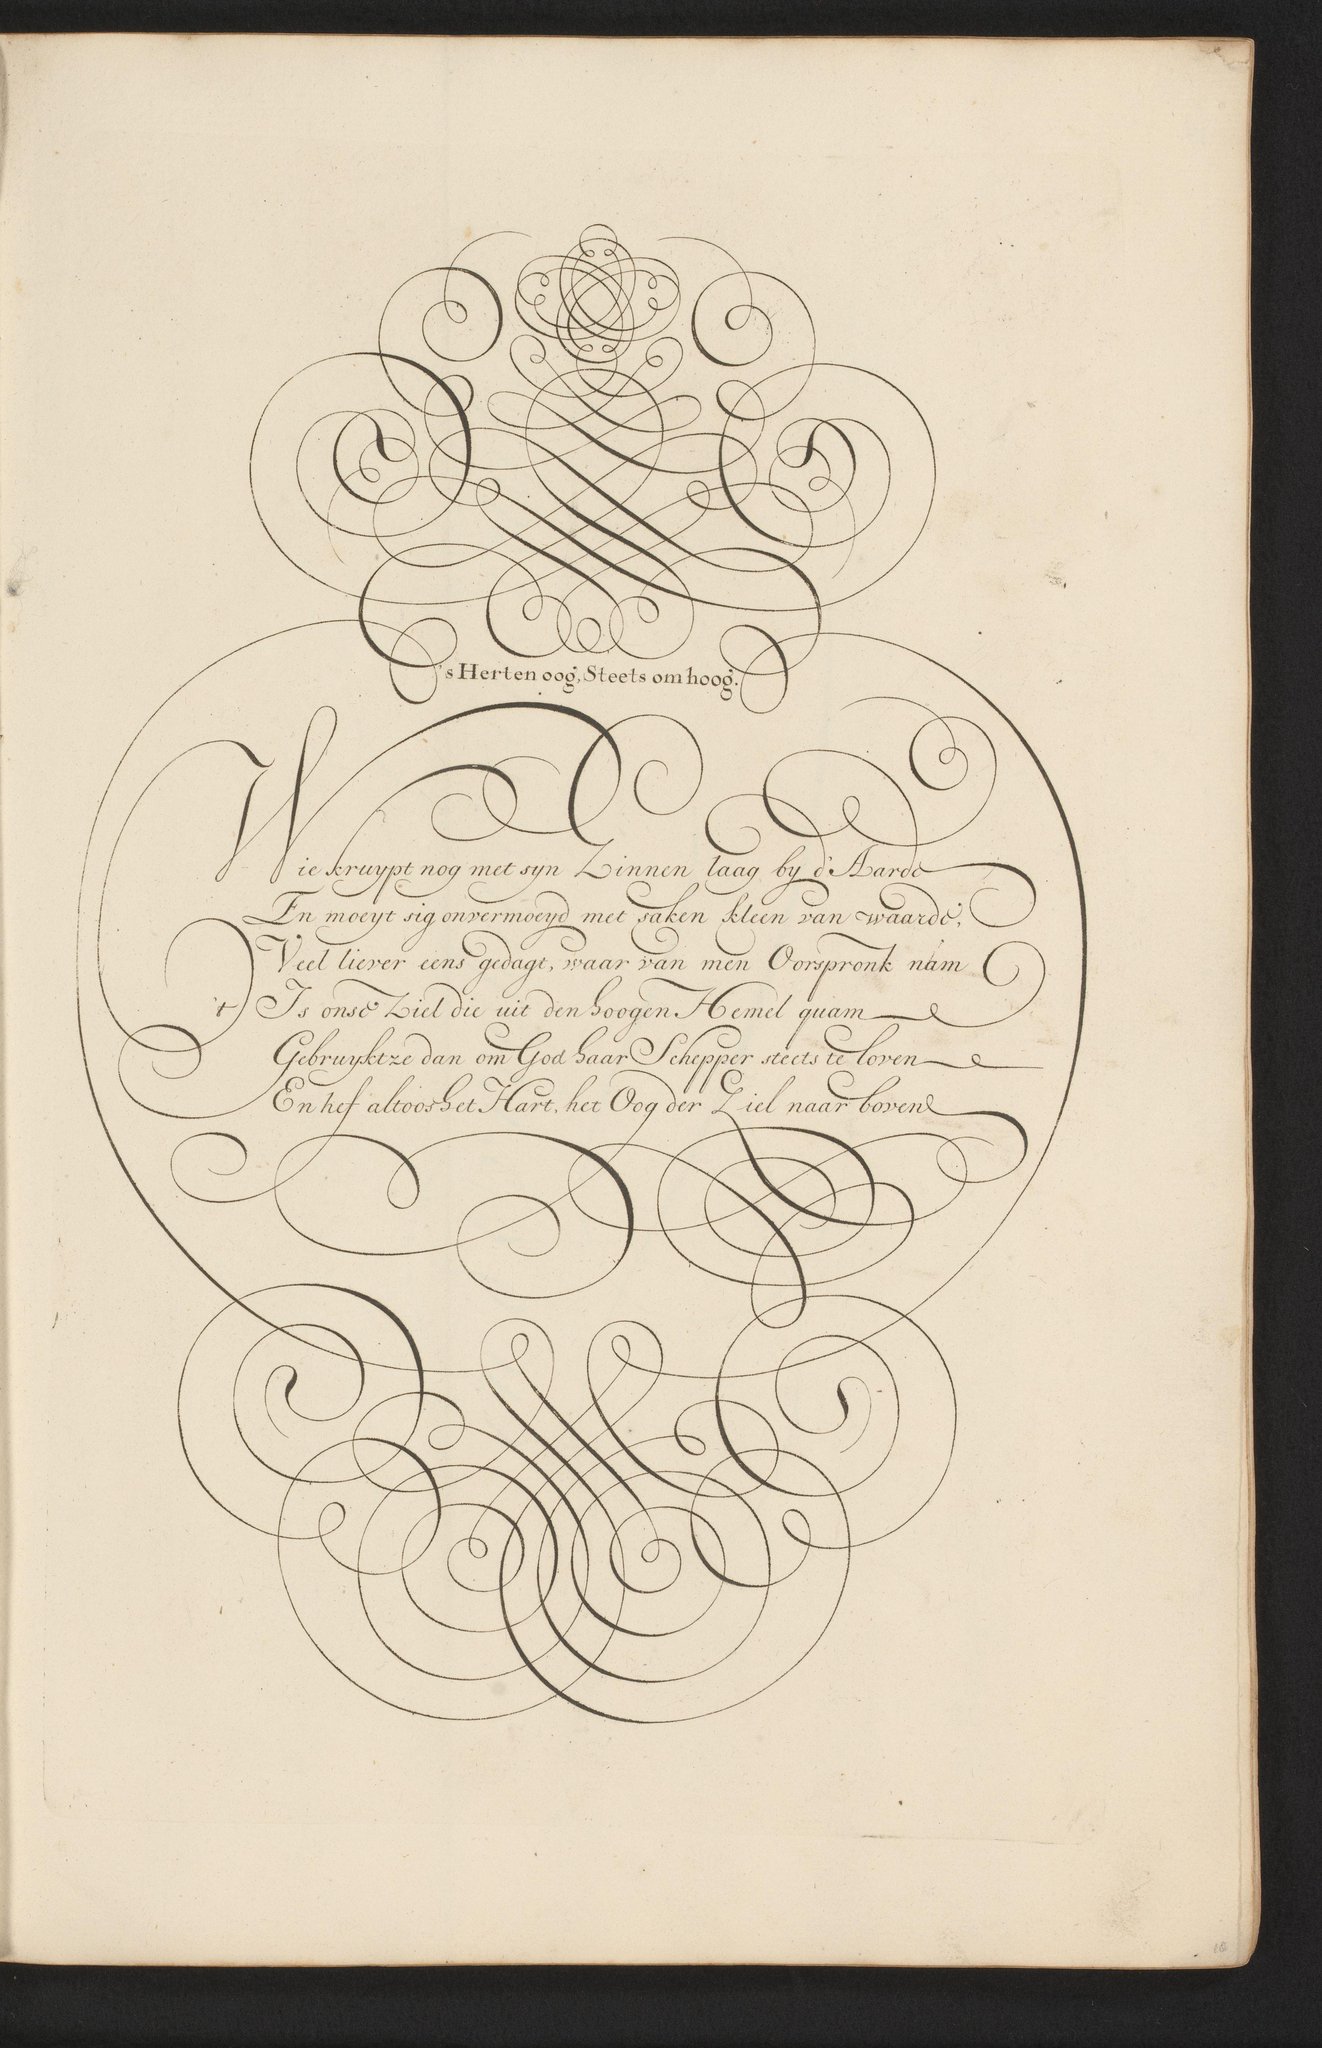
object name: ornament print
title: 's Herten oog, Steets om hoog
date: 1660-1751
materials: paper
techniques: engraving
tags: calligraphy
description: Schrijfvoorbeeld met een titel en zes regels tekst in het Nederlands: Wie kruypt nog met syn Zinnen ... Krulwerk in de vorm van een rijksappel. De prent maakt deel uit van een album